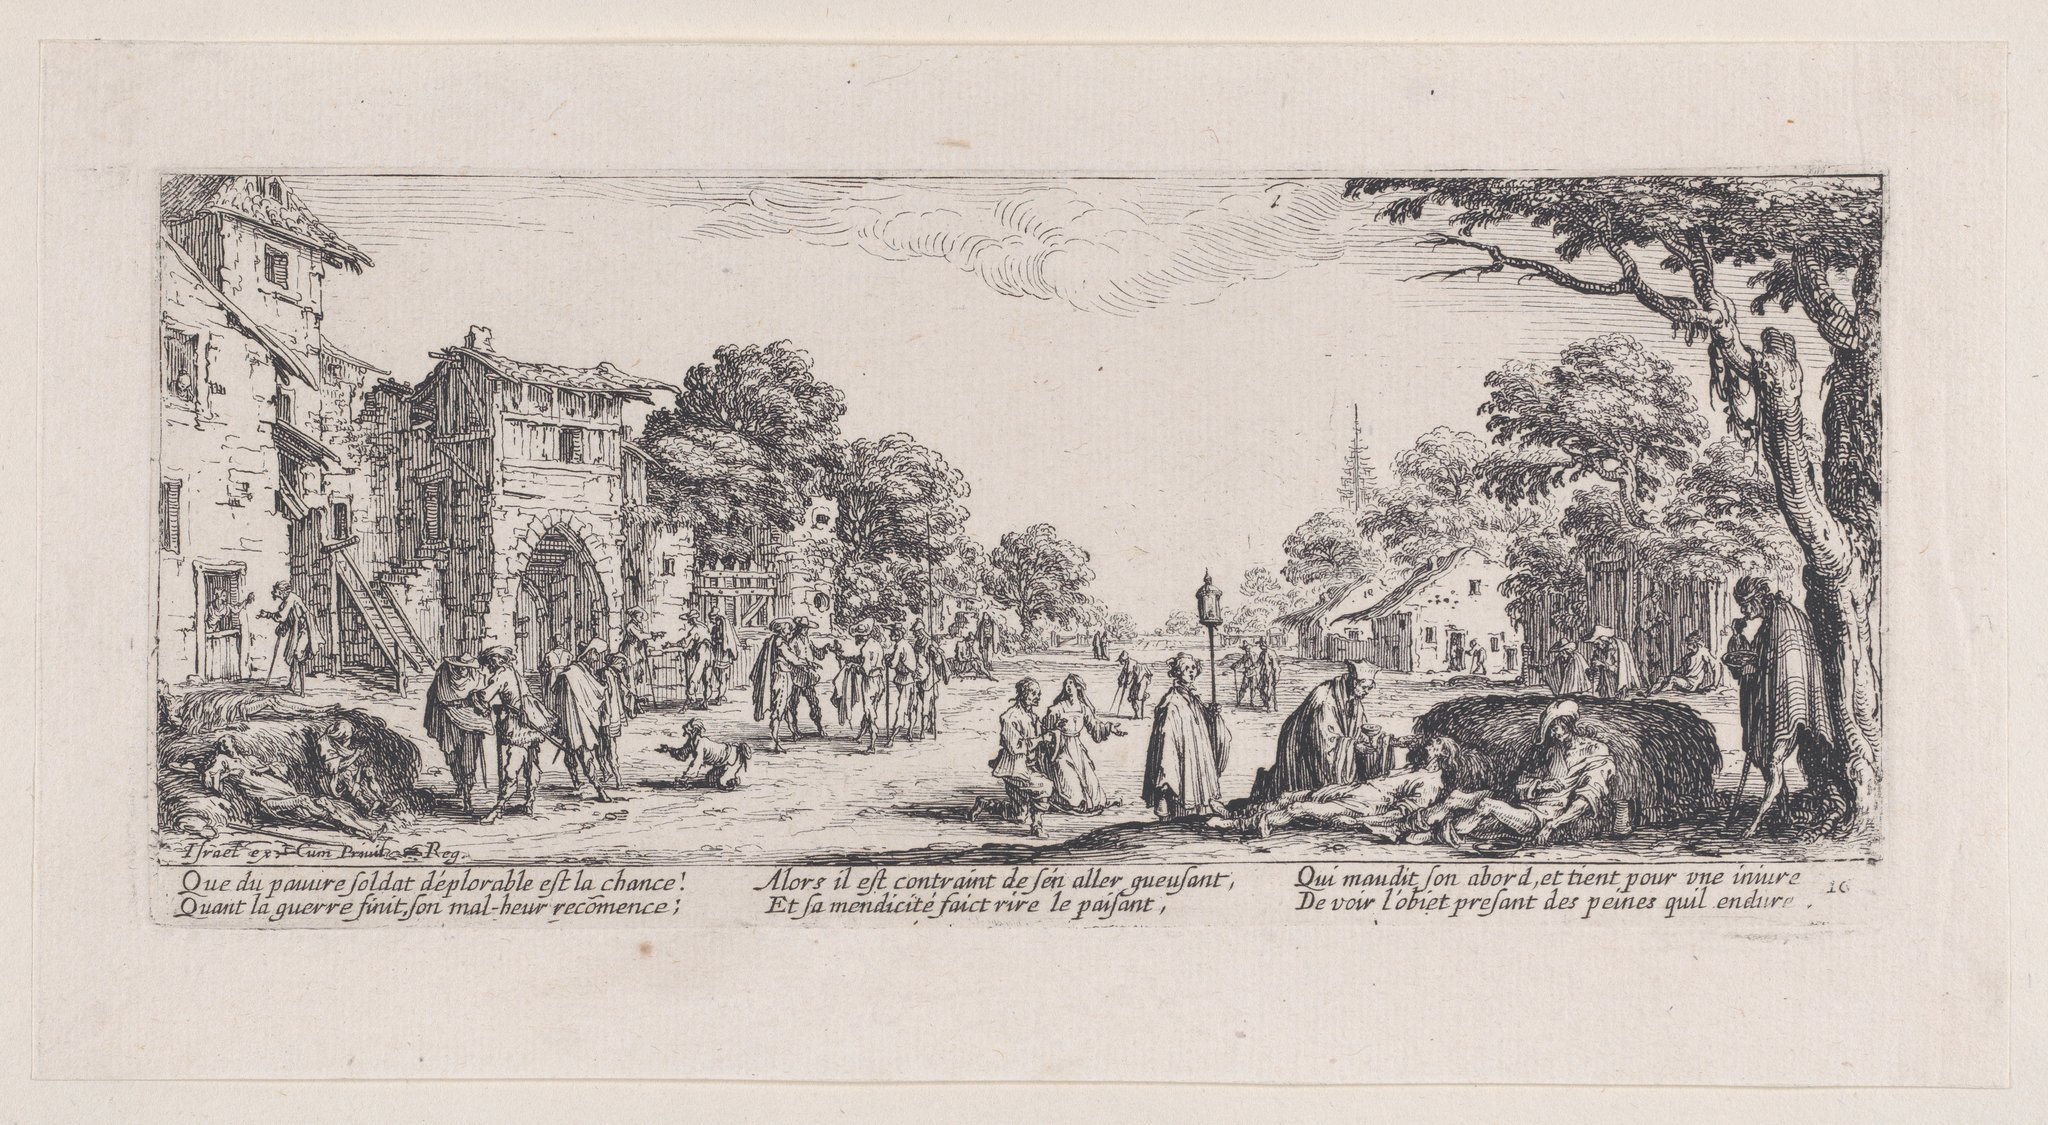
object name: print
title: Les Mourants sur le Bord des Rouges (The Dying on the Edge of the Road), plate 16 from "Les Misères et les Mal-Heures de la Guerre" (The Miseries and Misfortunes of War)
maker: jacques callot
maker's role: artist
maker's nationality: french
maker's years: 1592-1635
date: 1633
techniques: etching